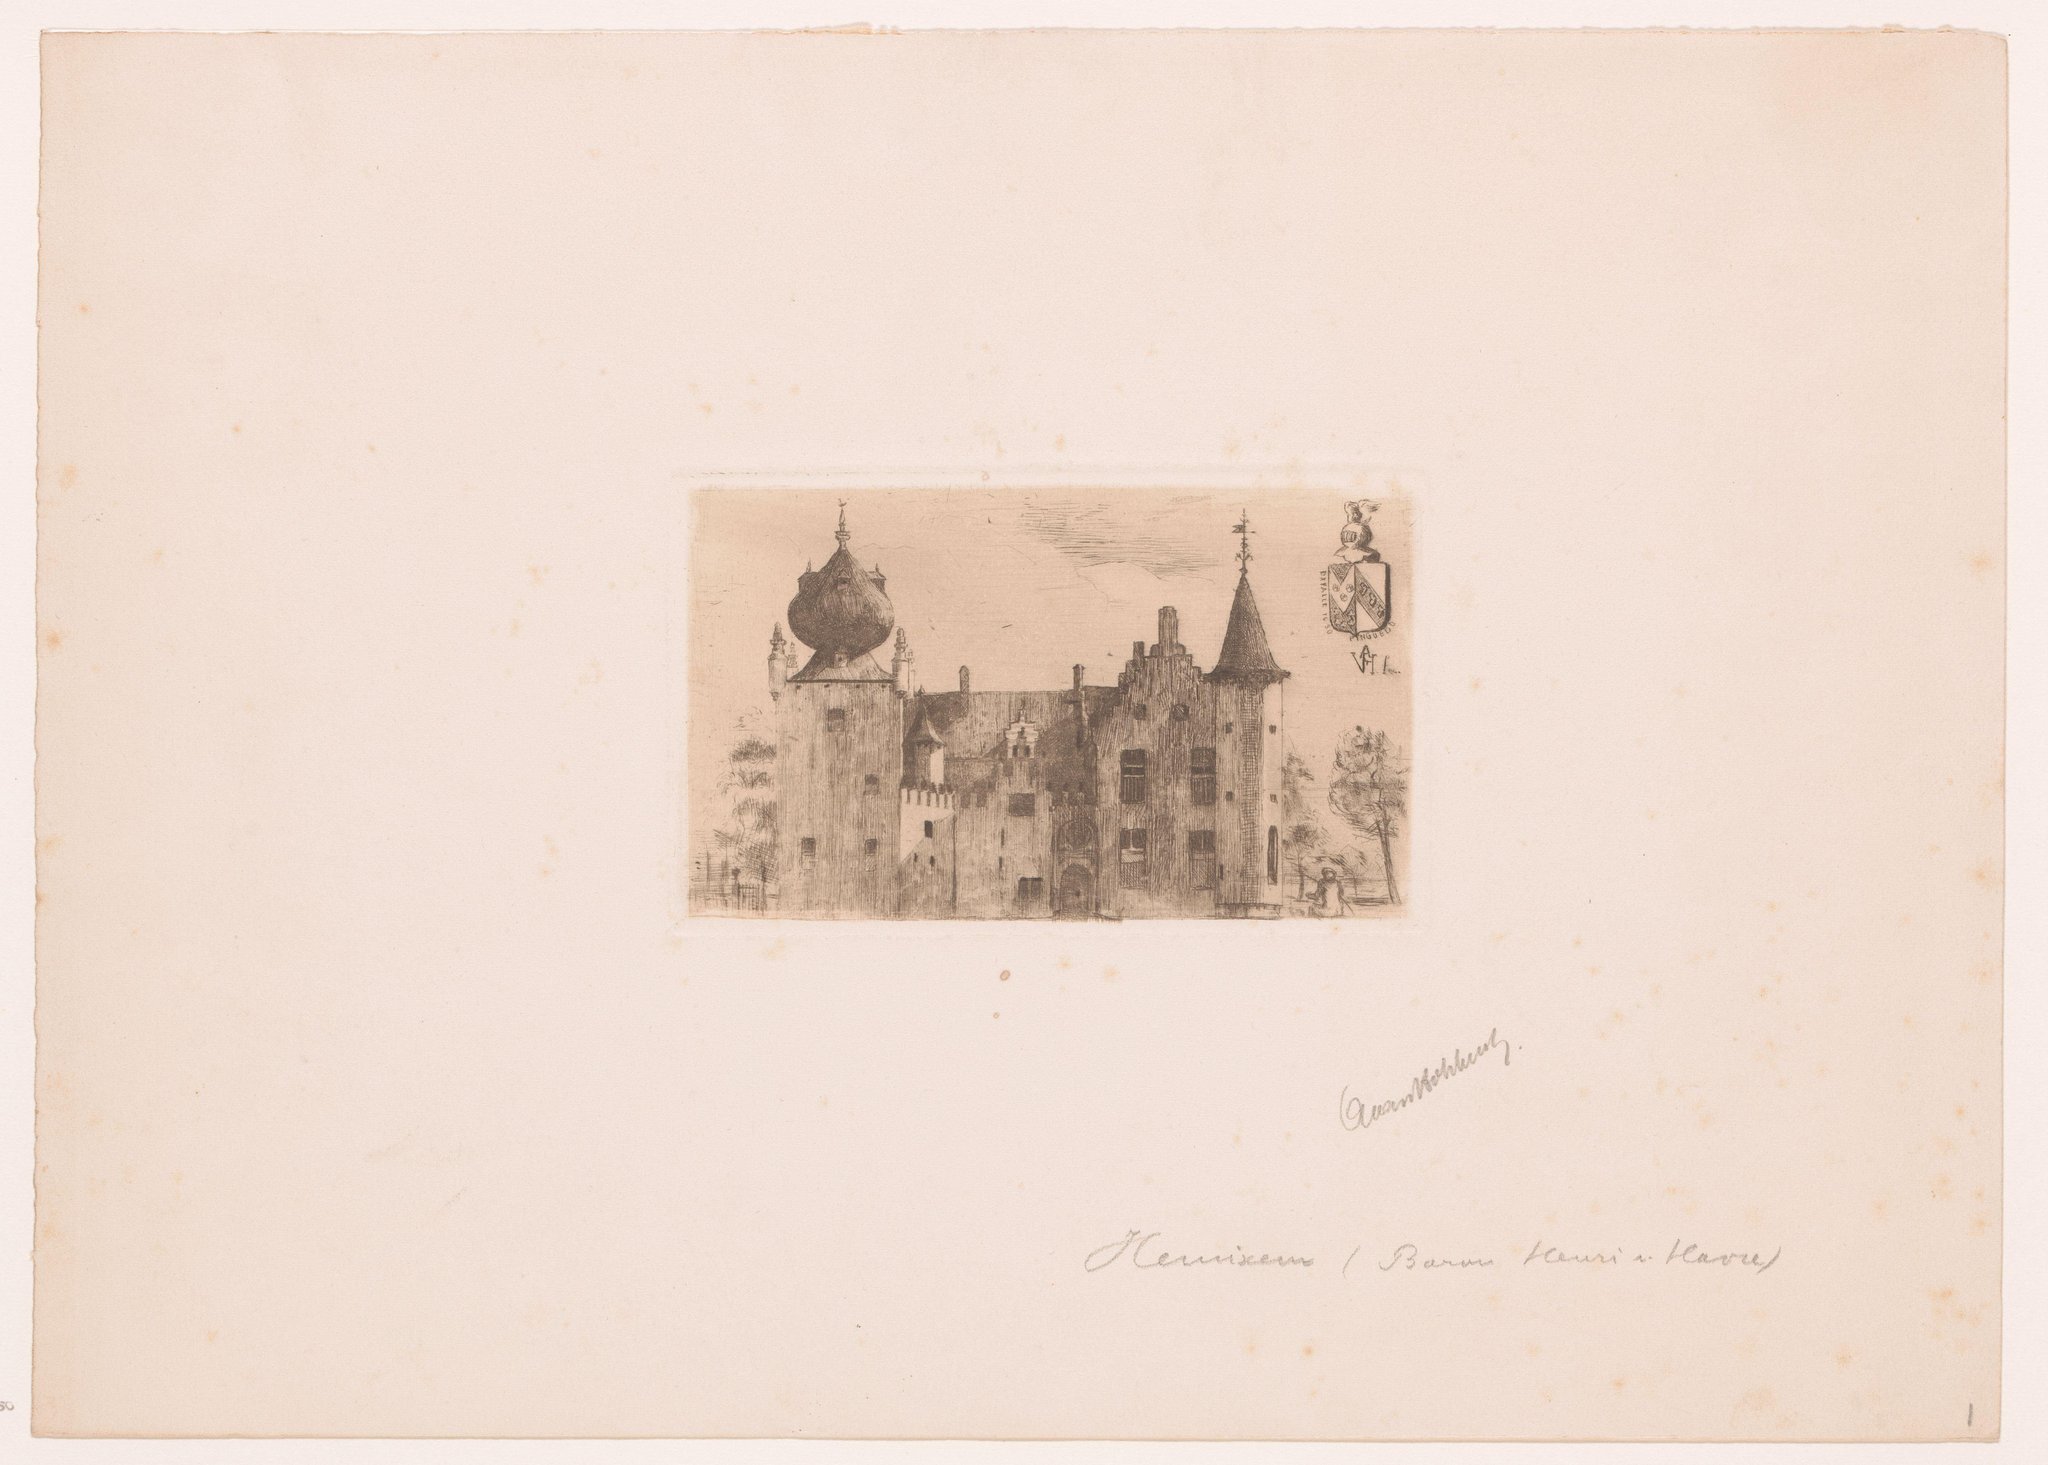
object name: print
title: Gezicht op het kasteel van baron Henri van Havre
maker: albert van holsbeeck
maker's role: print maker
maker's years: 1877-1948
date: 1887-1912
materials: paper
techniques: etching, intaglio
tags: castle, landscape with tower or castle, hemiksem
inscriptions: collector's mark: Lugt 2228